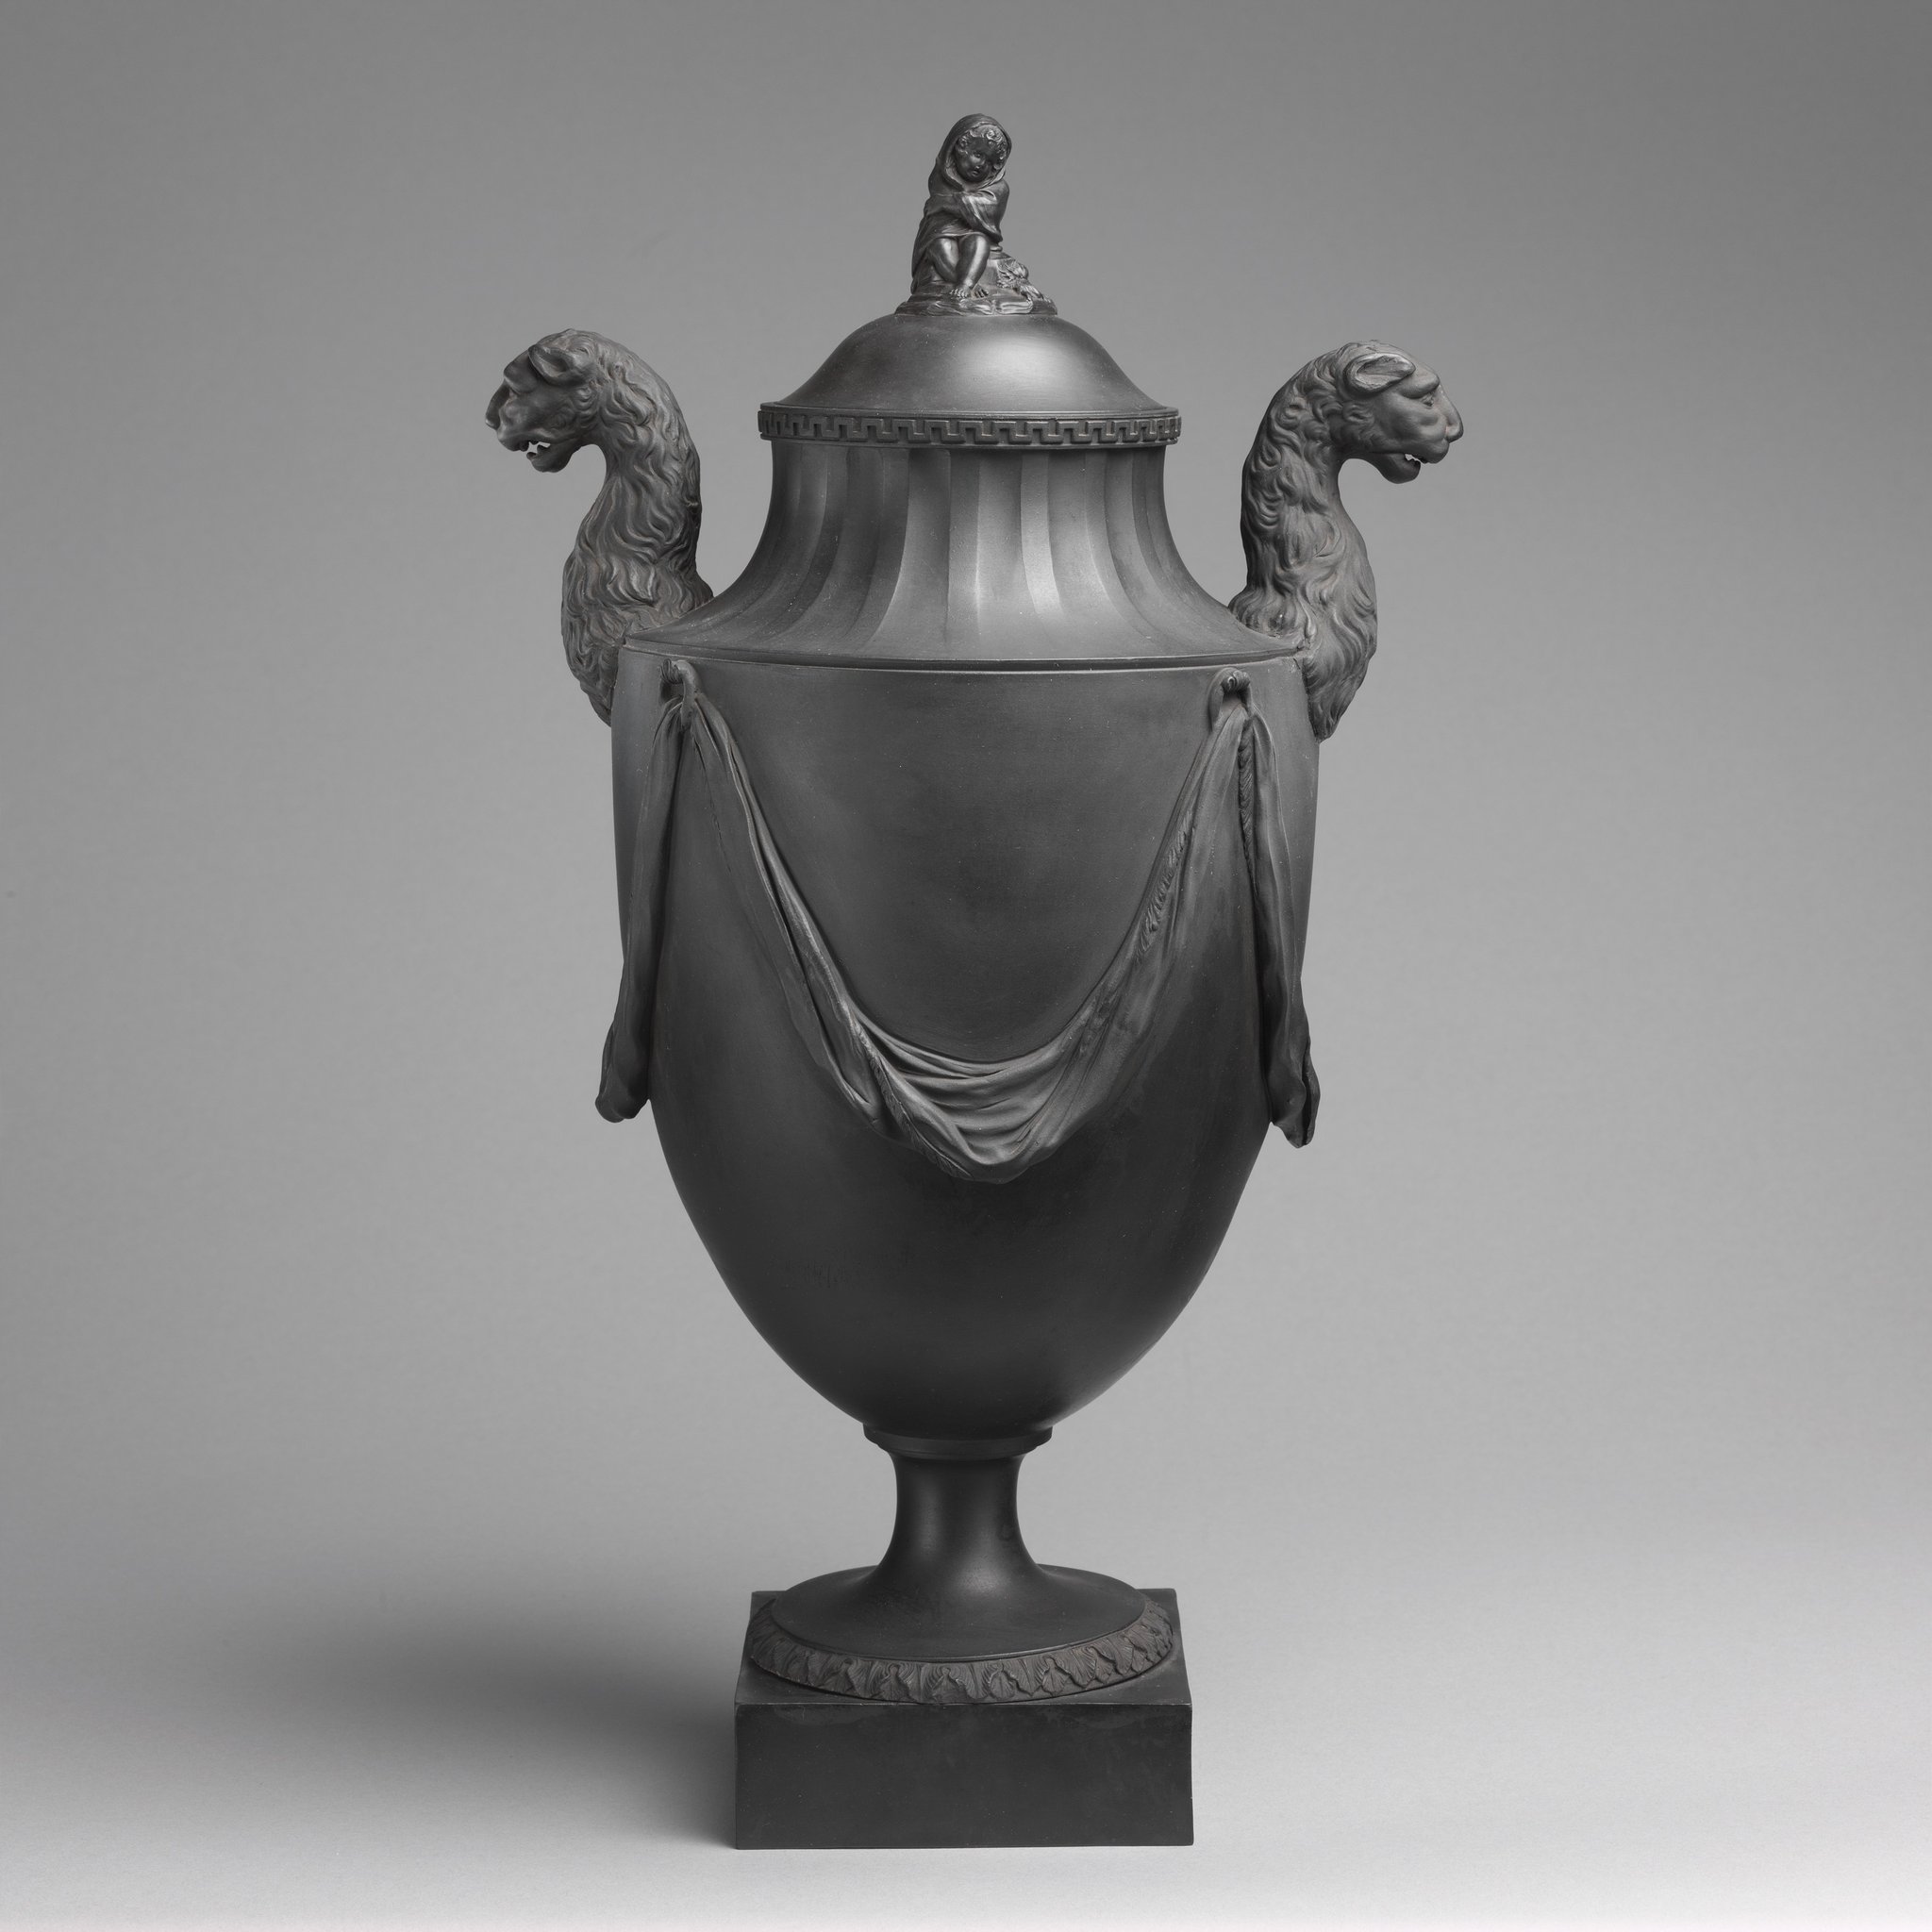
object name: vase with cover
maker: wedgwood and bentley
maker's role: factory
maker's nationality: british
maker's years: 1769-1780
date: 1769-1780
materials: stone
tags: human figures,tigers